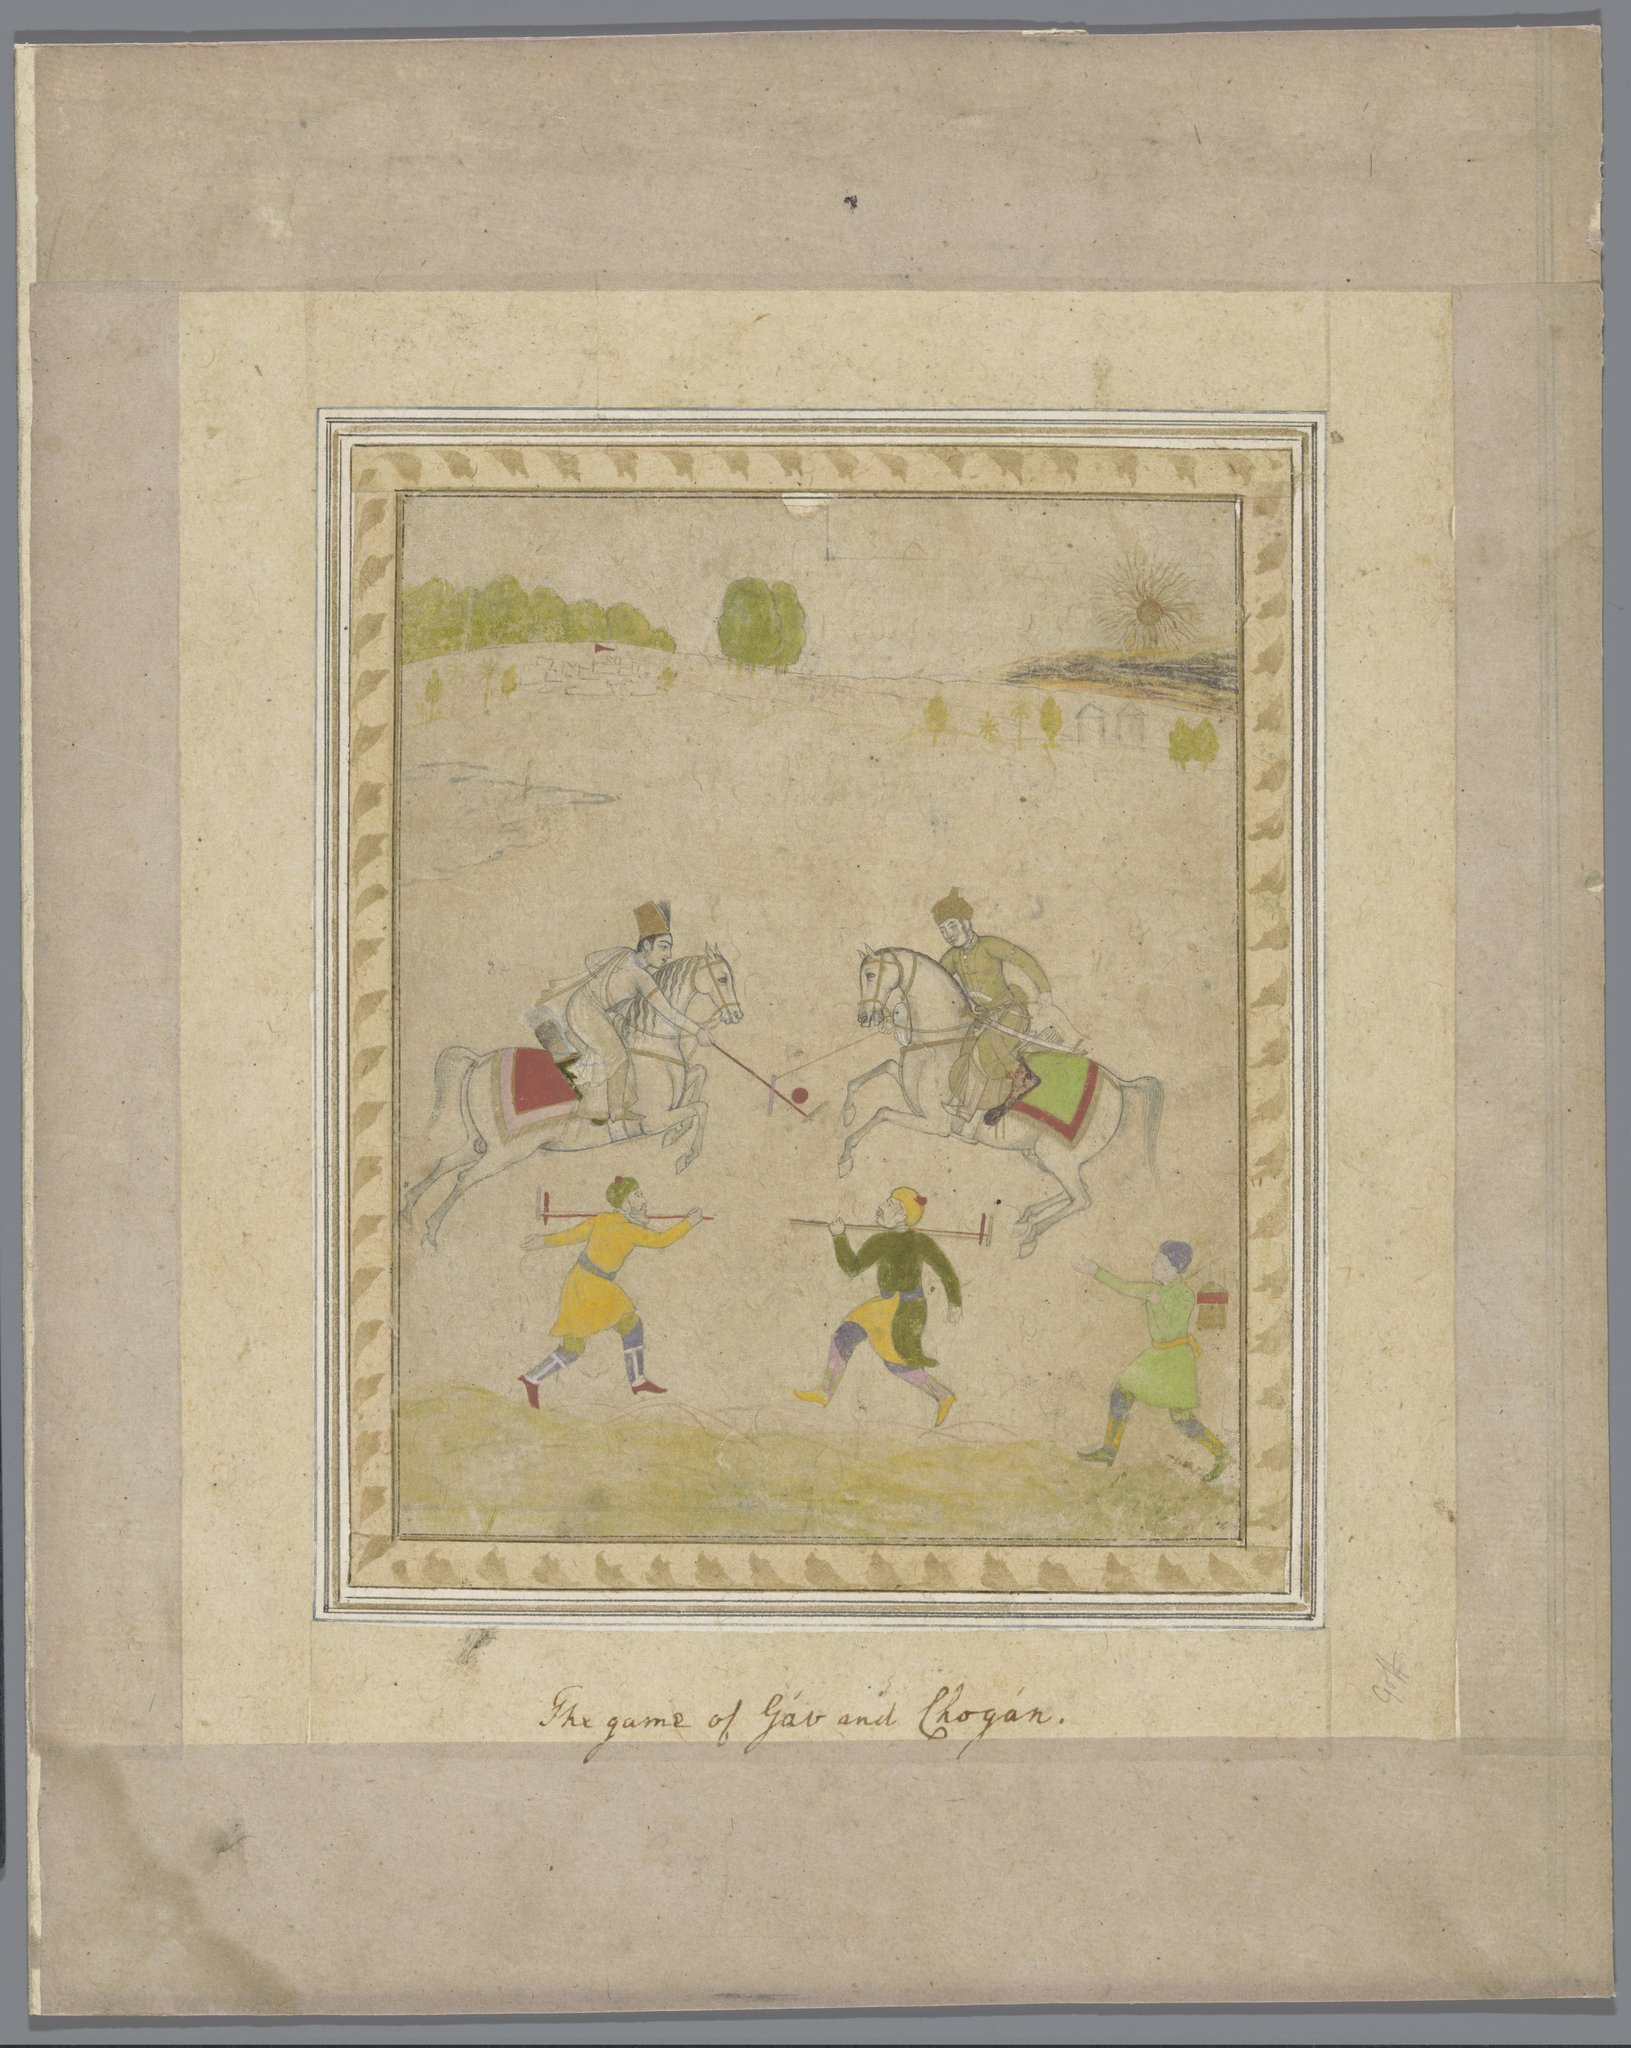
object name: drawing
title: Polo spelers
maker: Anonymous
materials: paper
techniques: brush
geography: india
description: Twee mannen te paard en drie staande op de grond. Onderaan de tekst: The game of Gav and Chogan. Op de achterkant inscriptie in Perzisch schrift.